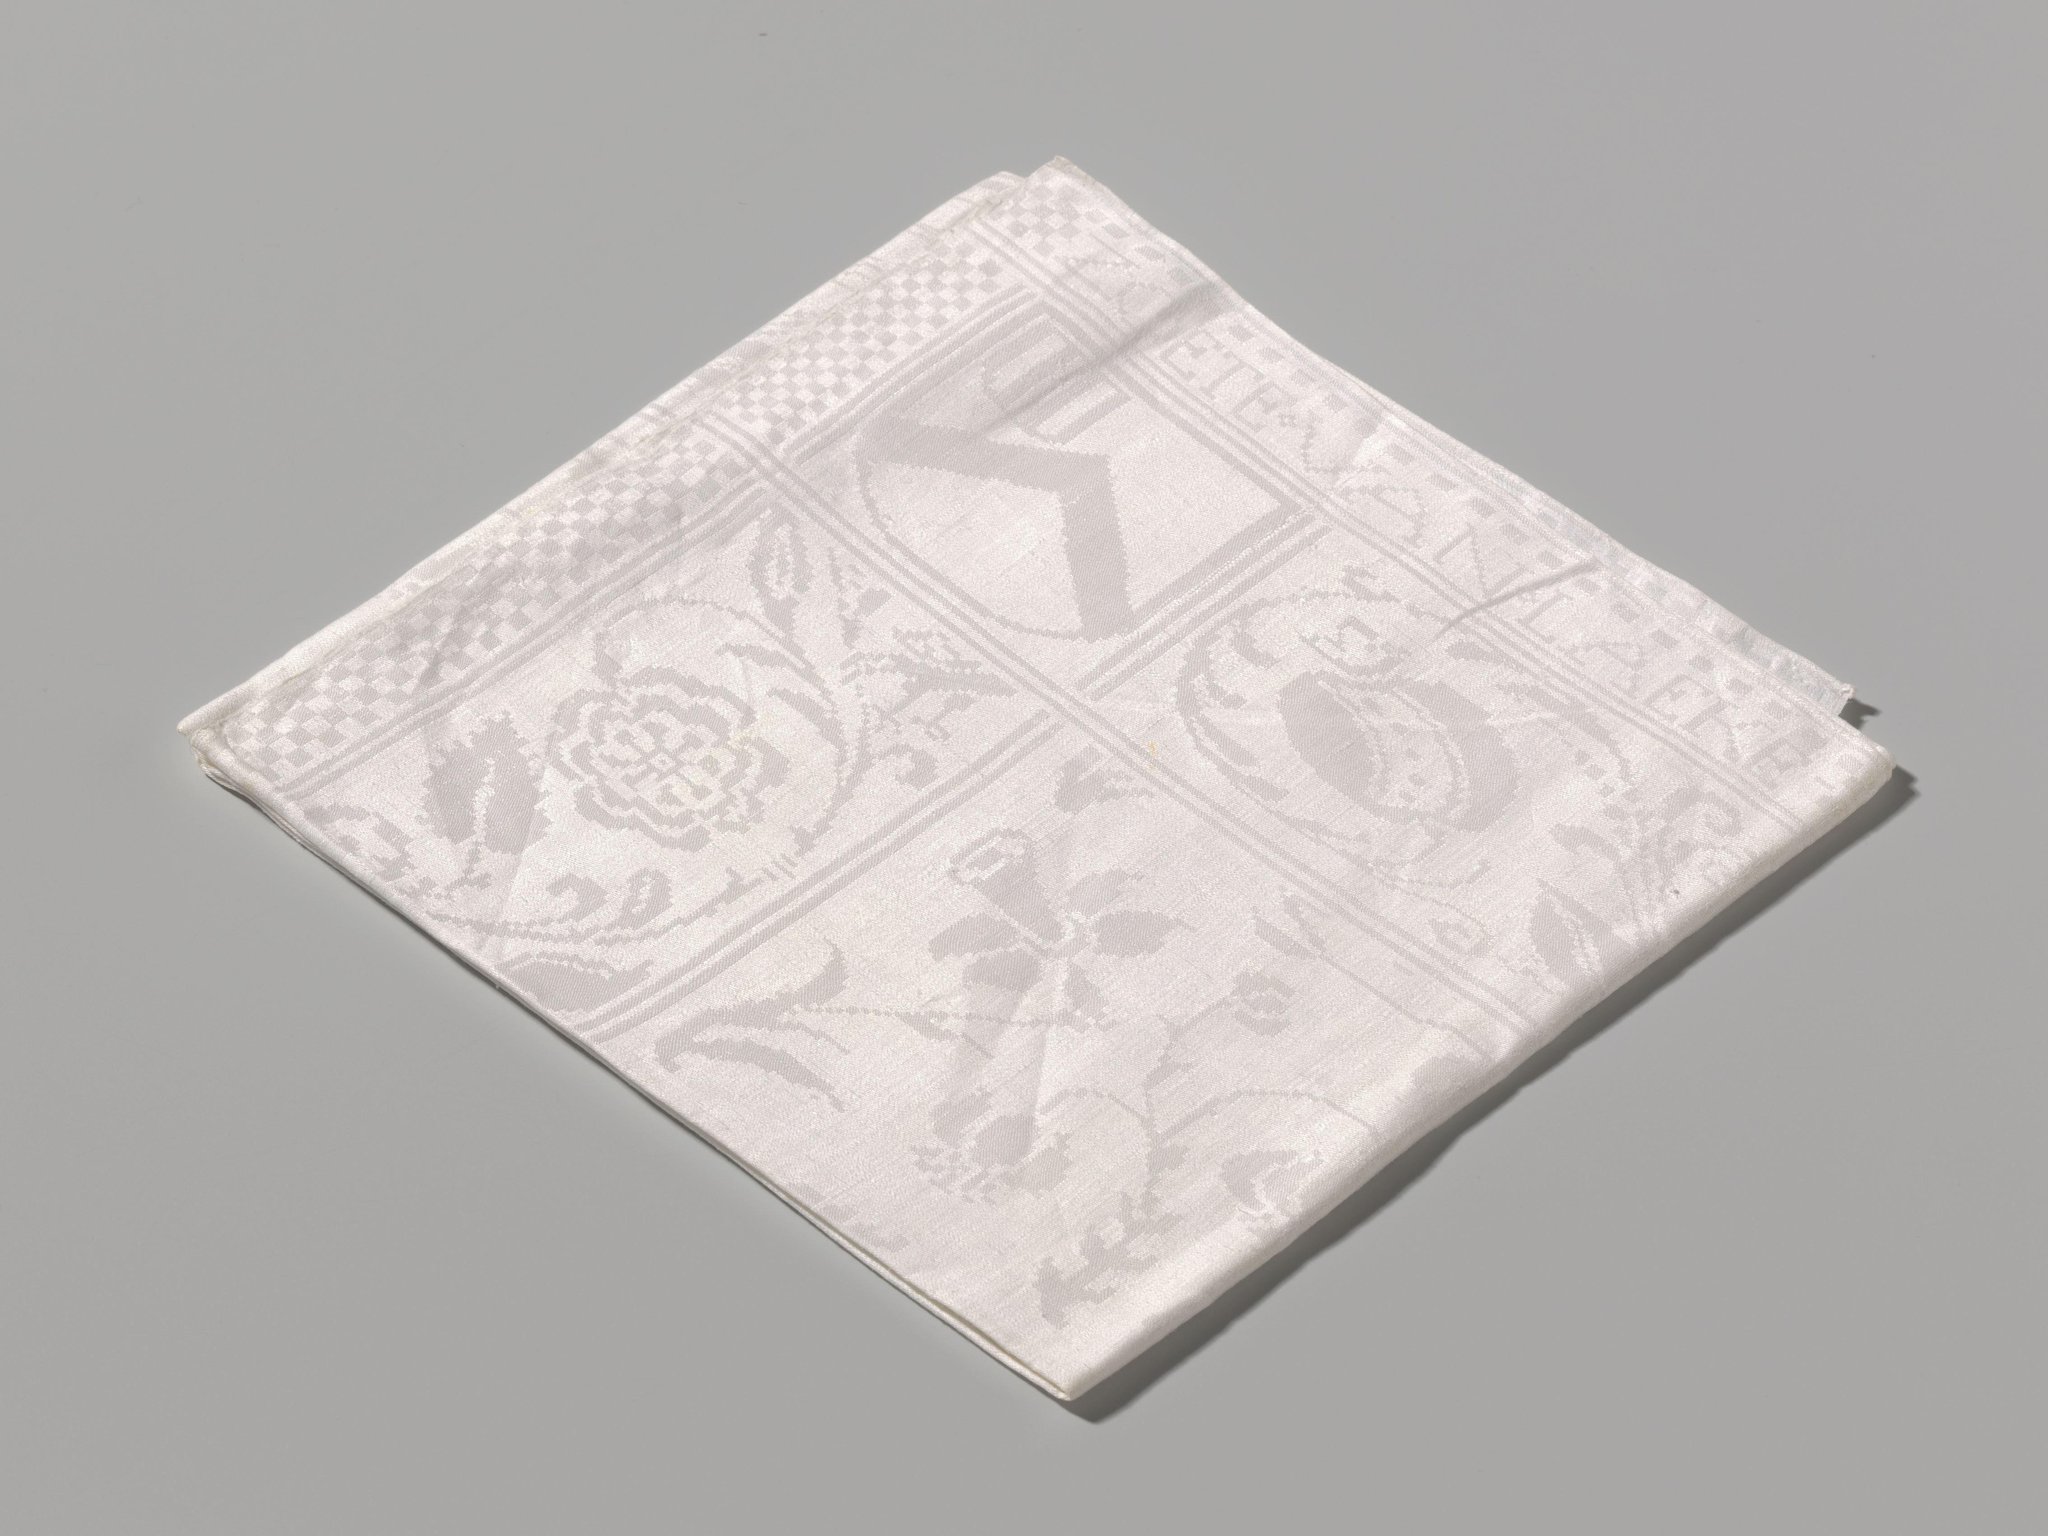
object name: napkin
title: Servet van wit linnen met een patroon van gestrooide bloemen en met de wapen- en naaminwevingen ZOETE VAN LAEKE en HERTAING.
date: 1603-1627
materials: linen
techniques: damask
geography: northern netherlands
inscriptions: mark: ‘GL 22’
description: Witlinnen damasten servet met een patroon van gestrooide bloemen met de wapen- en naaminwevingen "ZOETE VAN LAEKE" en "HERTAIGN", gemerkt GL 22.